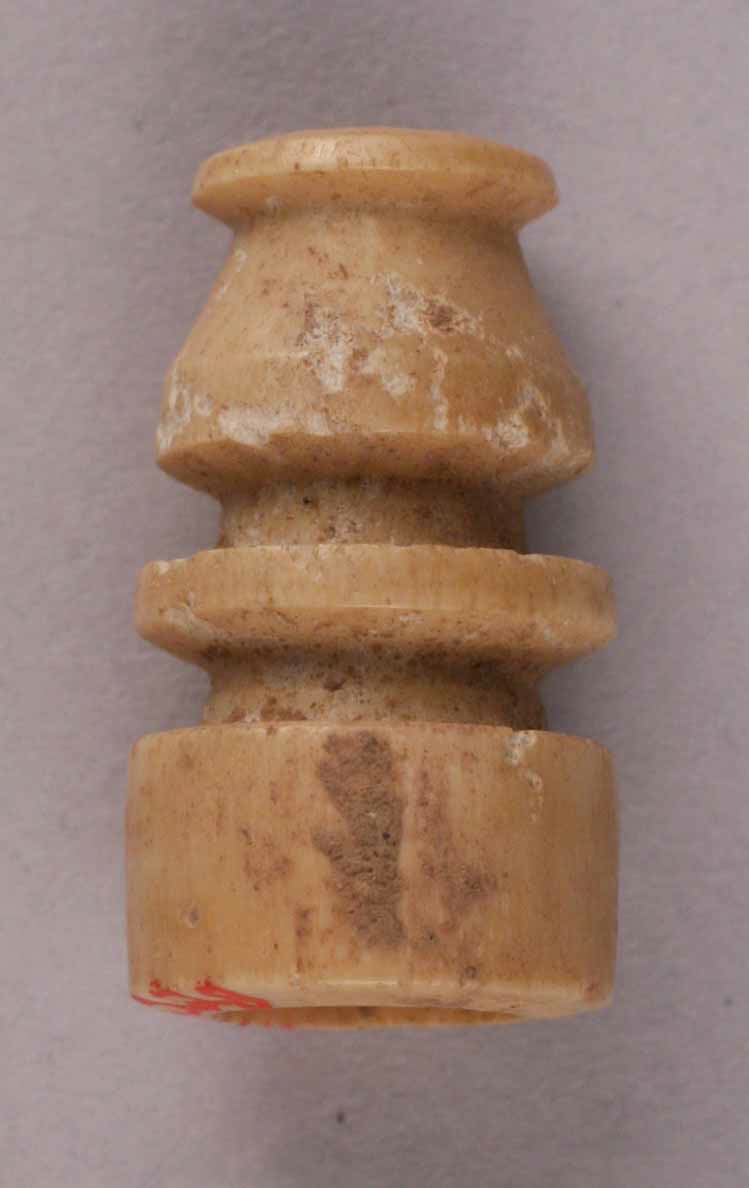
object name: handle or ornament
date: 801-1000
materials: bone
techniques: carving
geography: iran